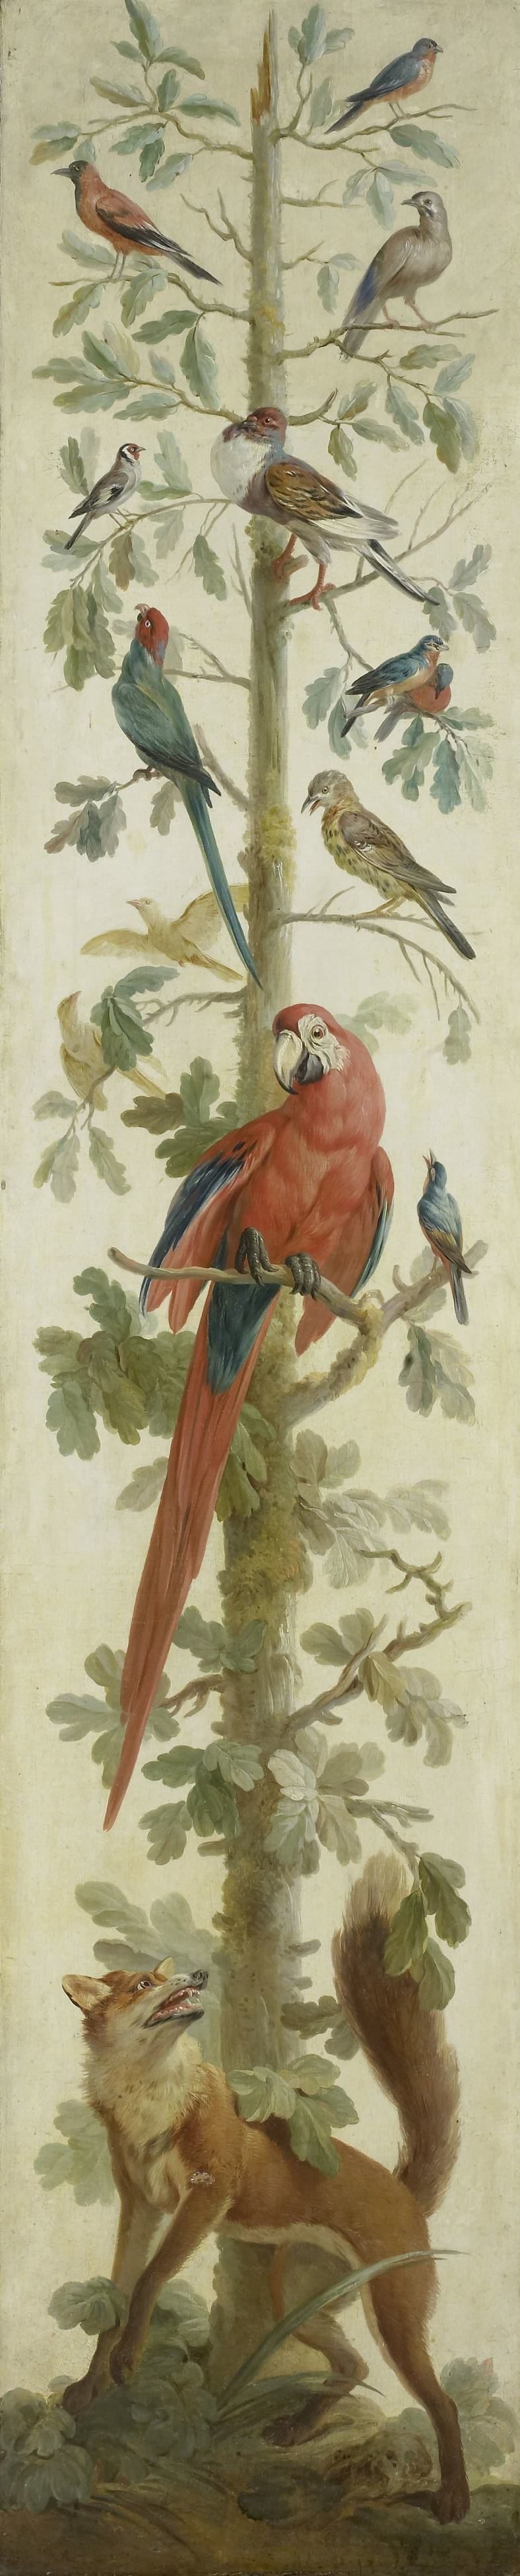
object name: painting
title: Decorative Depiction with Plants and Animals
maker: Anonymous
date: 1760-1800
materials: canvas, oil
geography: france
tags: birds, ornamental birds: parrot, beasts of prey, predatory animals: fox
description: French school, c. 1775. Four decorative paintings with plants and animals.